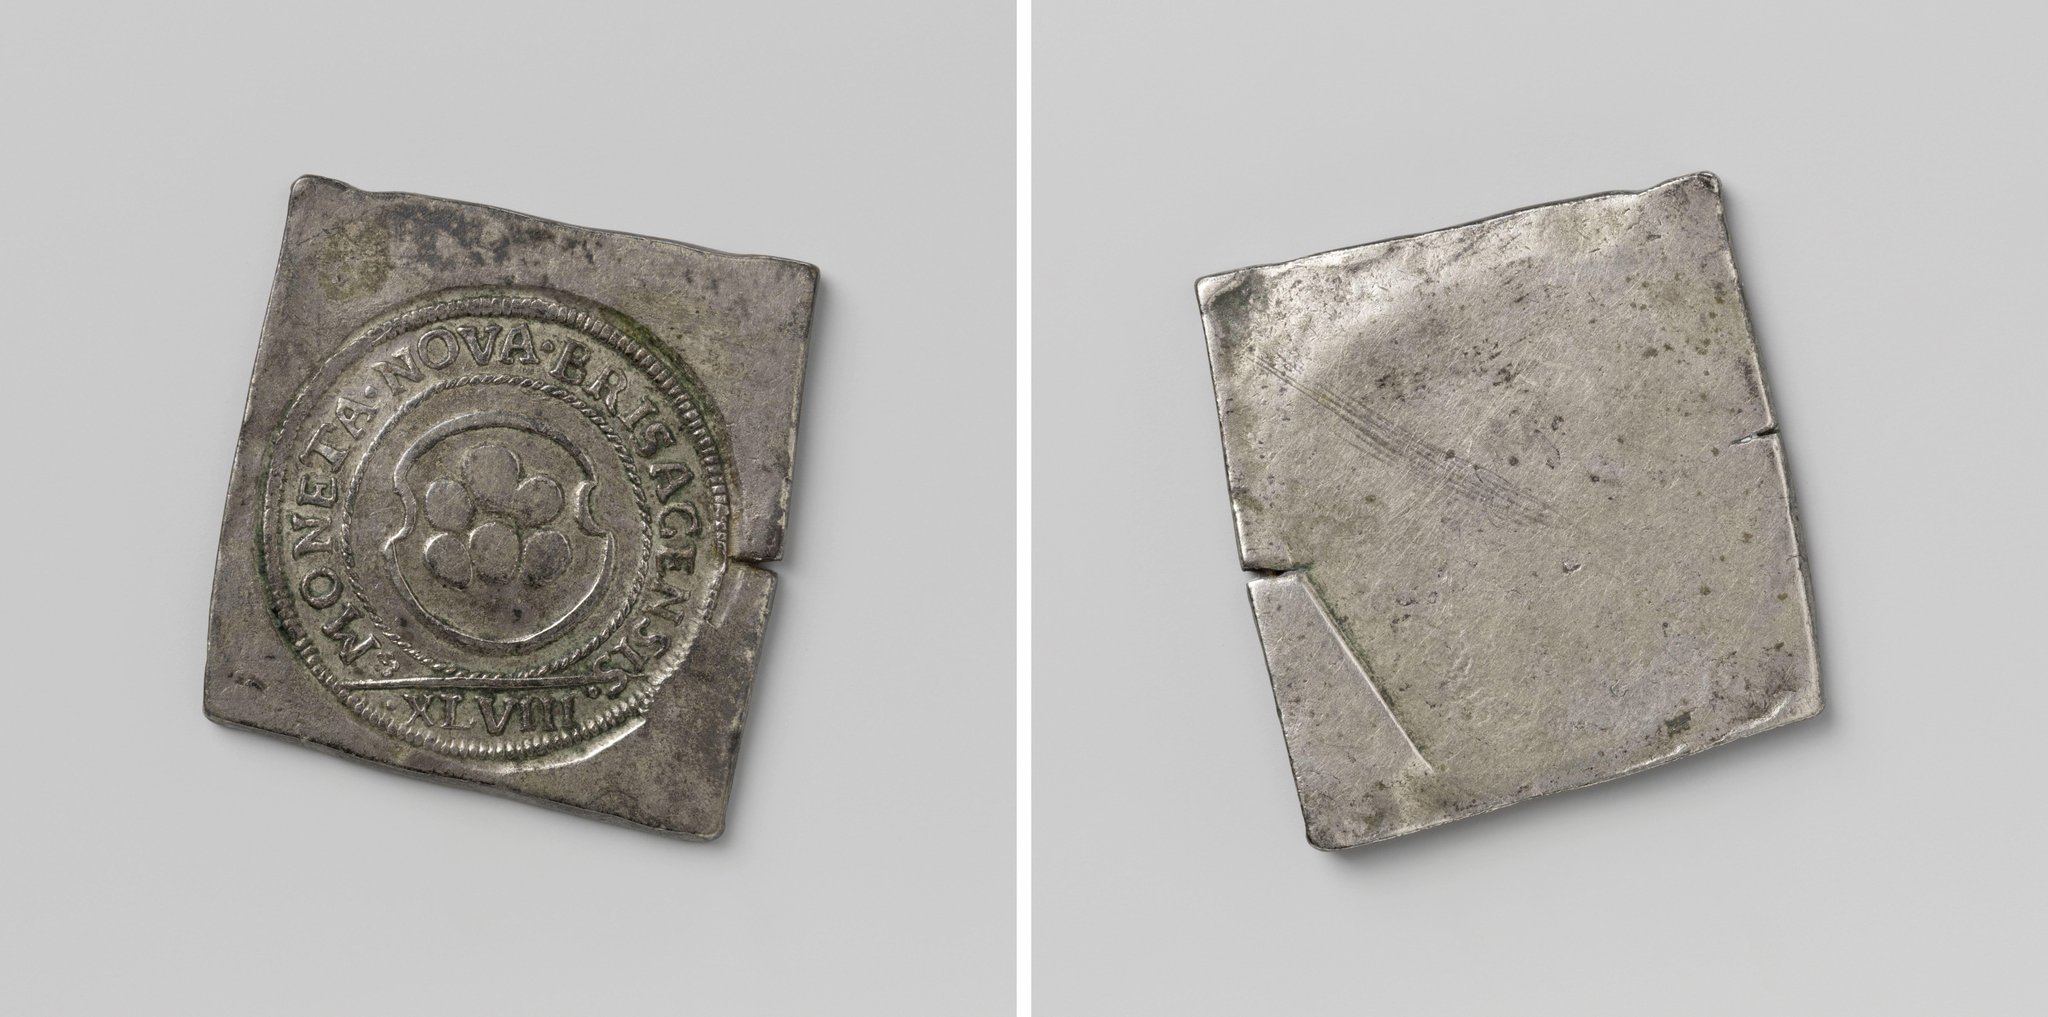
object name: siege coin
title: Achtenveertig batz, noodmunt uit Breisach, geslagen tijdens het beleg door de Zweden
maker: Anonymous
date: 1633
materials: silver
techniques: striking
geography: breisach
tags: breisach, beleg van breisach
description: eenzijdige, bijna rechthoekige noodmunt, aan rechterzijde ingescheurd. Voorzijde: in ronde stempel: wapenschild binnen omschrift; afsnede: Romeinse cijfer XLVIII. Keerzijde: blanco